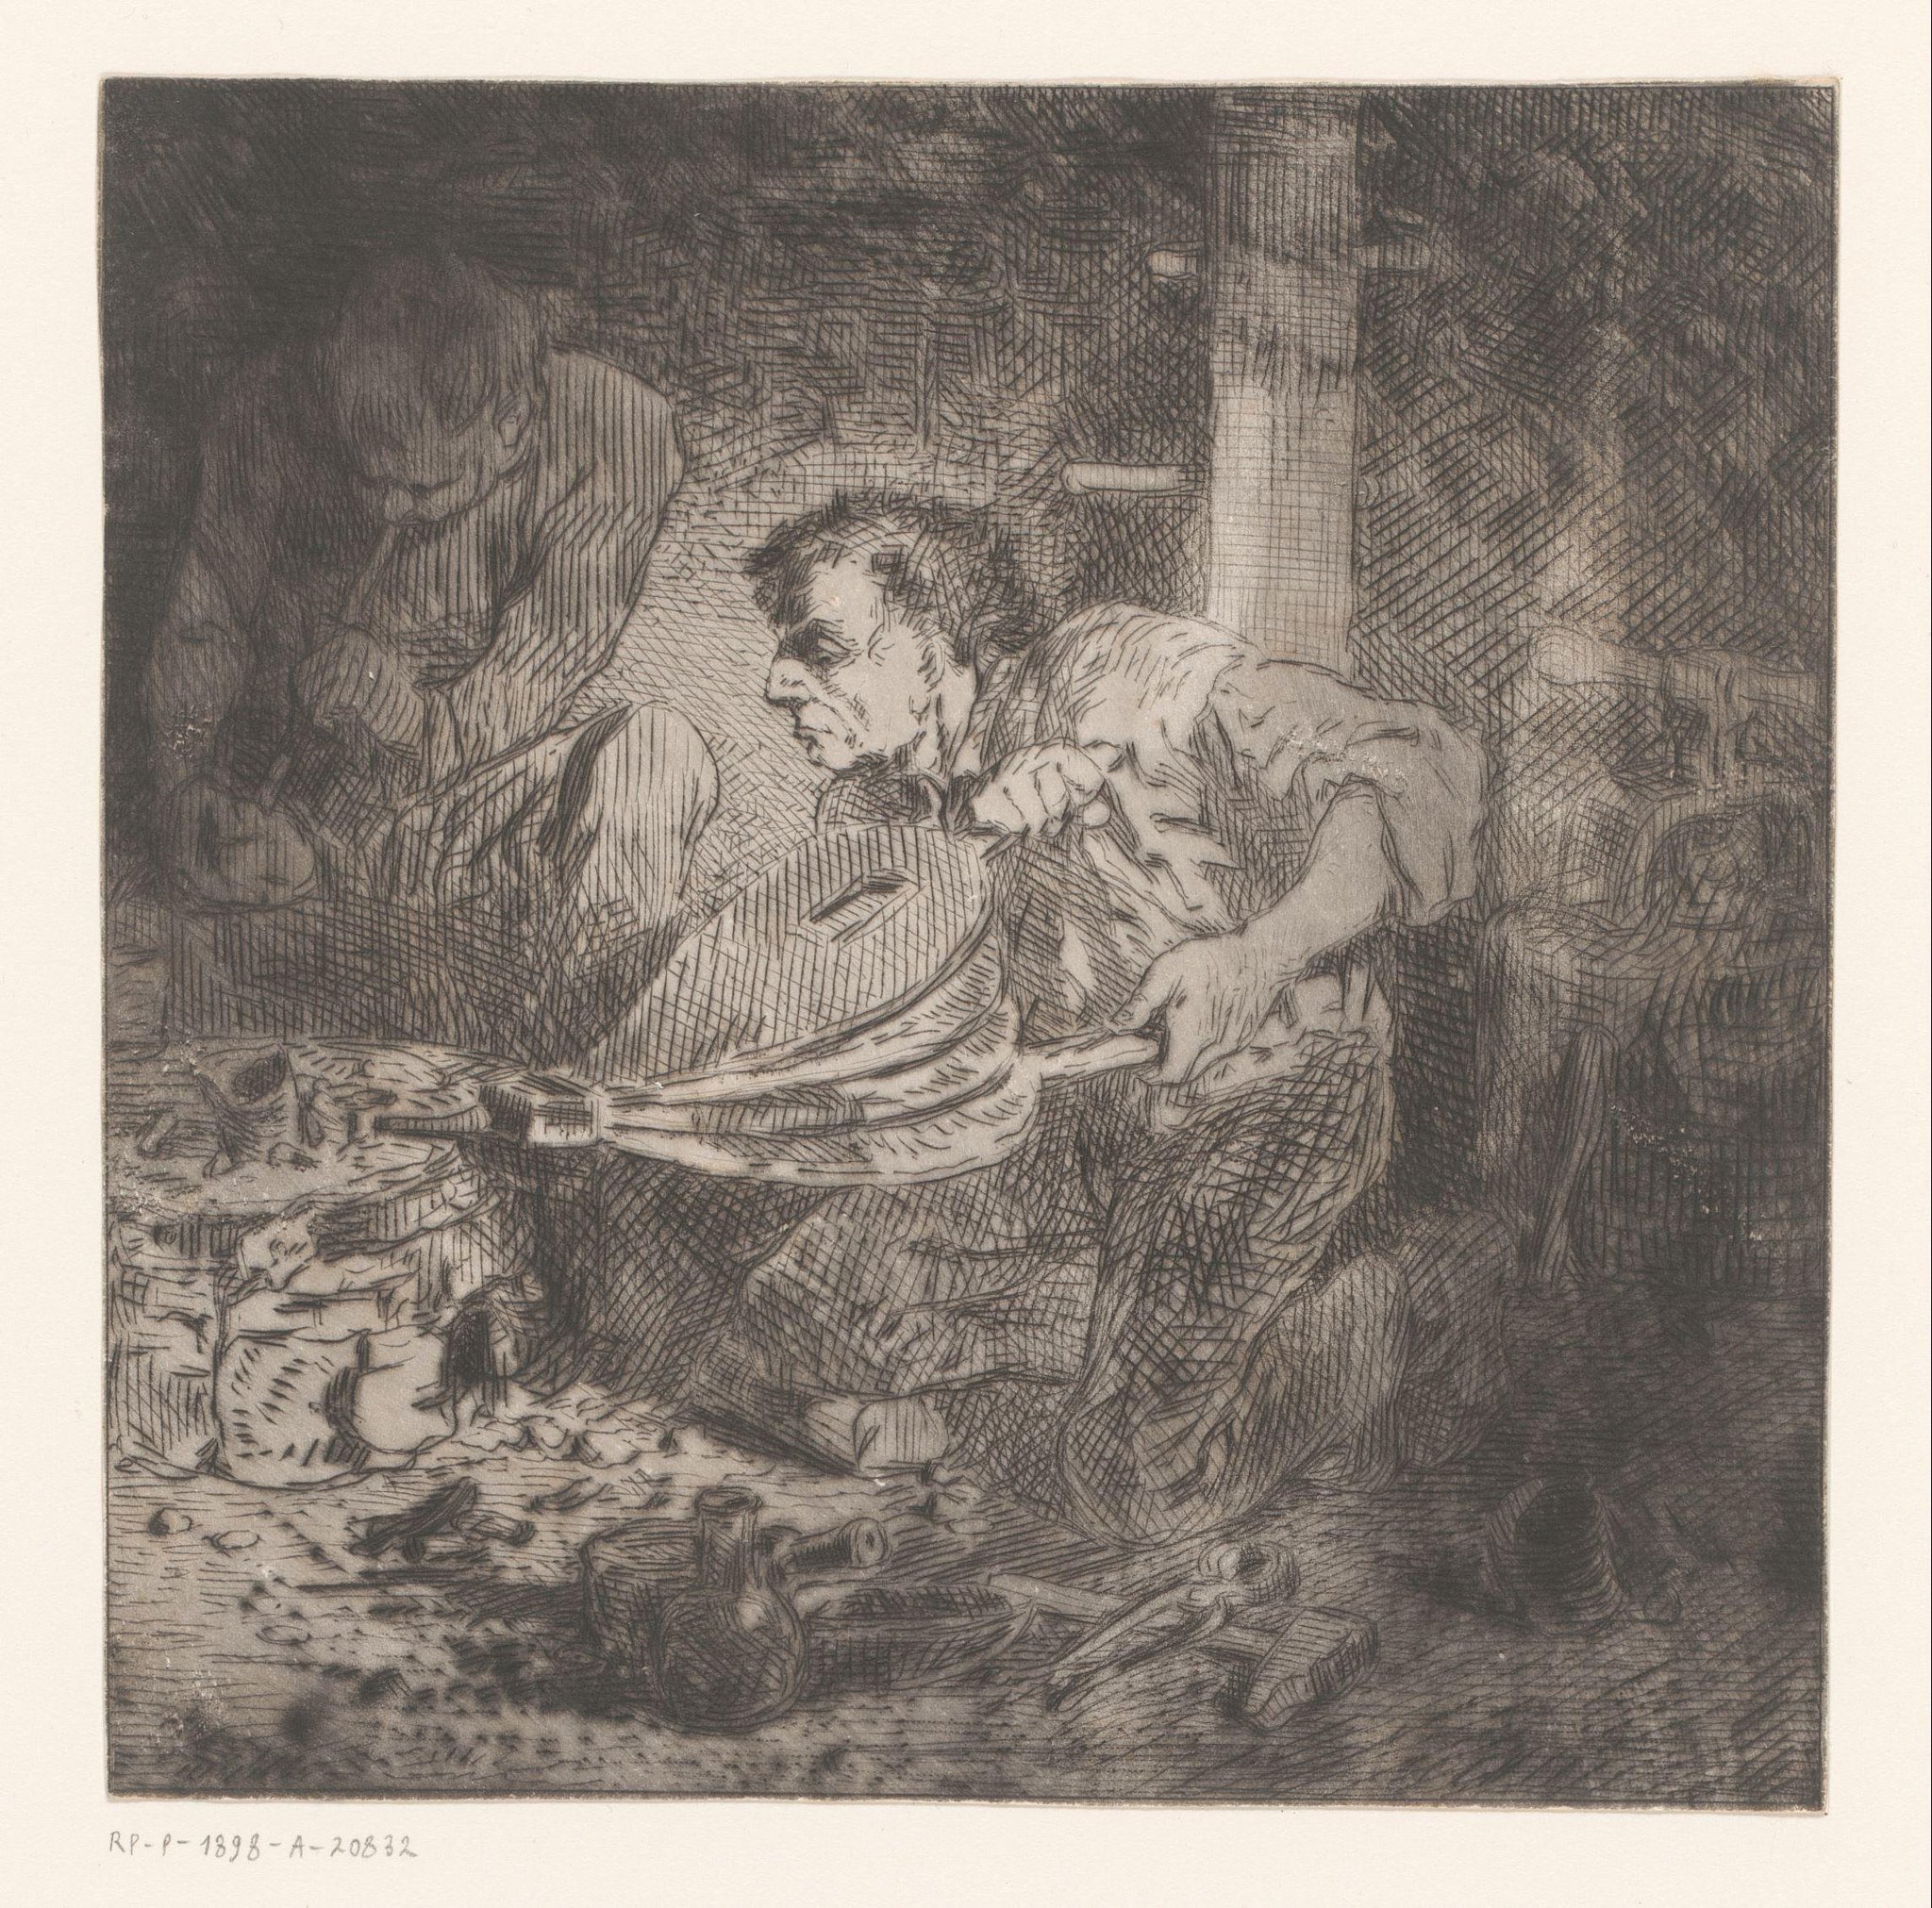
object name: print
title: Smid met blaasbalg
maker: charles emile jacque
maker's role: draughtsman, painter, print maker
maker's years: 1813-1894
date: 1848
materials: paper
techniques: drypoint, engraving, etching, intaglio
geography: france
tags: smith, blacksmith, bellows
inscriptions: collector's mark: Lugt 964